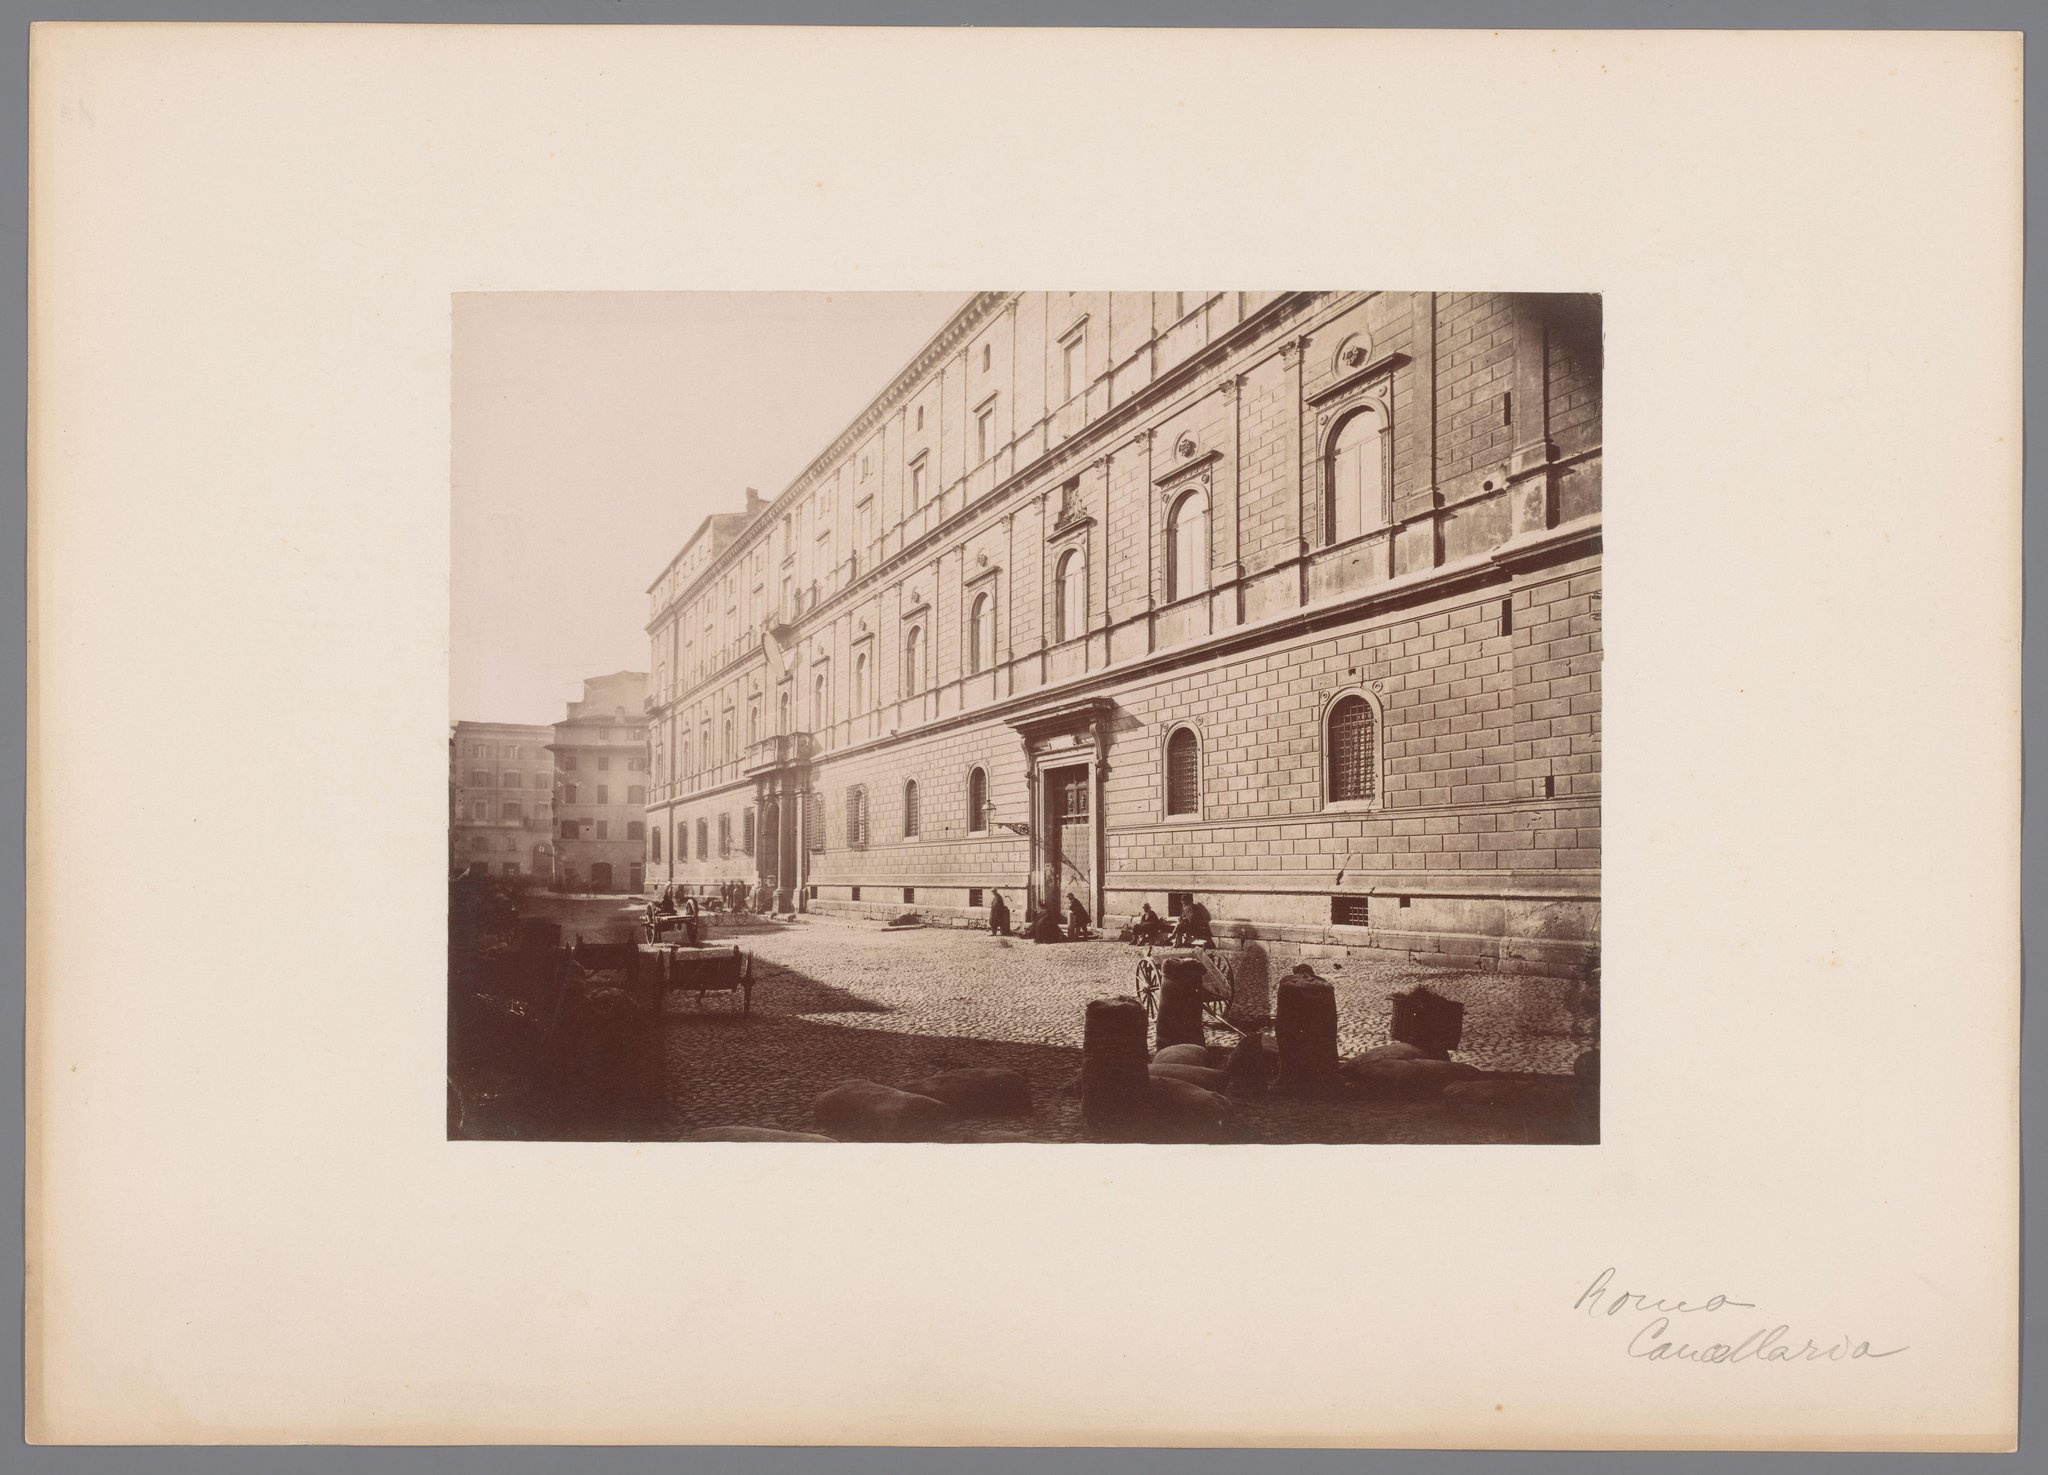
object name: photograph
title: Exterieur van het Paleis van de Kanselarij te Rome, Italië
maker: Anonymous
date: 1851-1900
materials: cardboard, paper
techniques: albumen print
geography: rome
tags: exterior ~ representation of a building, hôtel, i.e. small palace in city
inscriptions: inscription: ‘Cancellaria’, number: ‘1060’, number: ‘50’